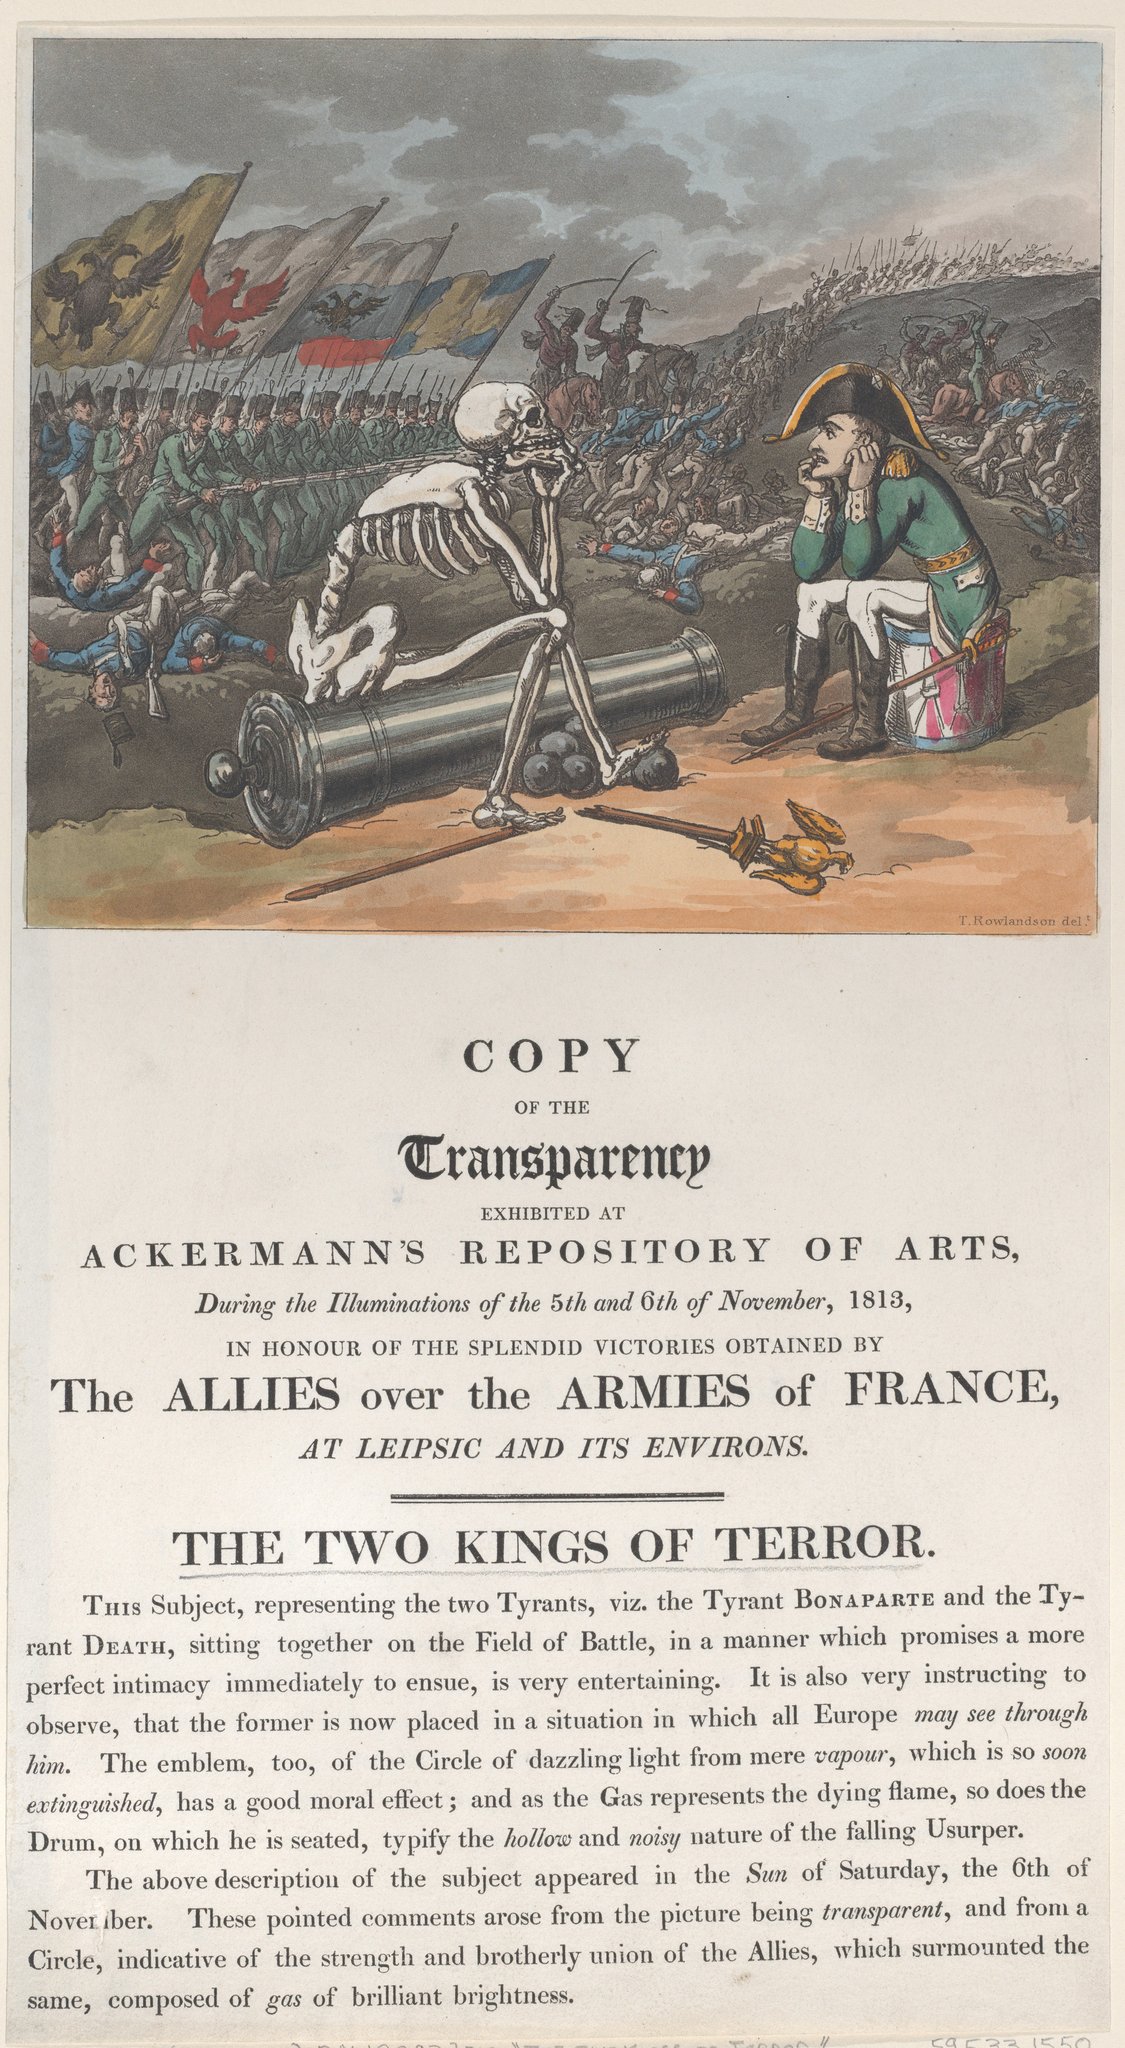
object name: print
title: The Two Kings of Terror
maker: thomas rowlandson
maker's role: artist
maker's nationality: british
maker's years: 1757-1827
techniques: etching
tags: satire,napoleon i,skeletons,politics